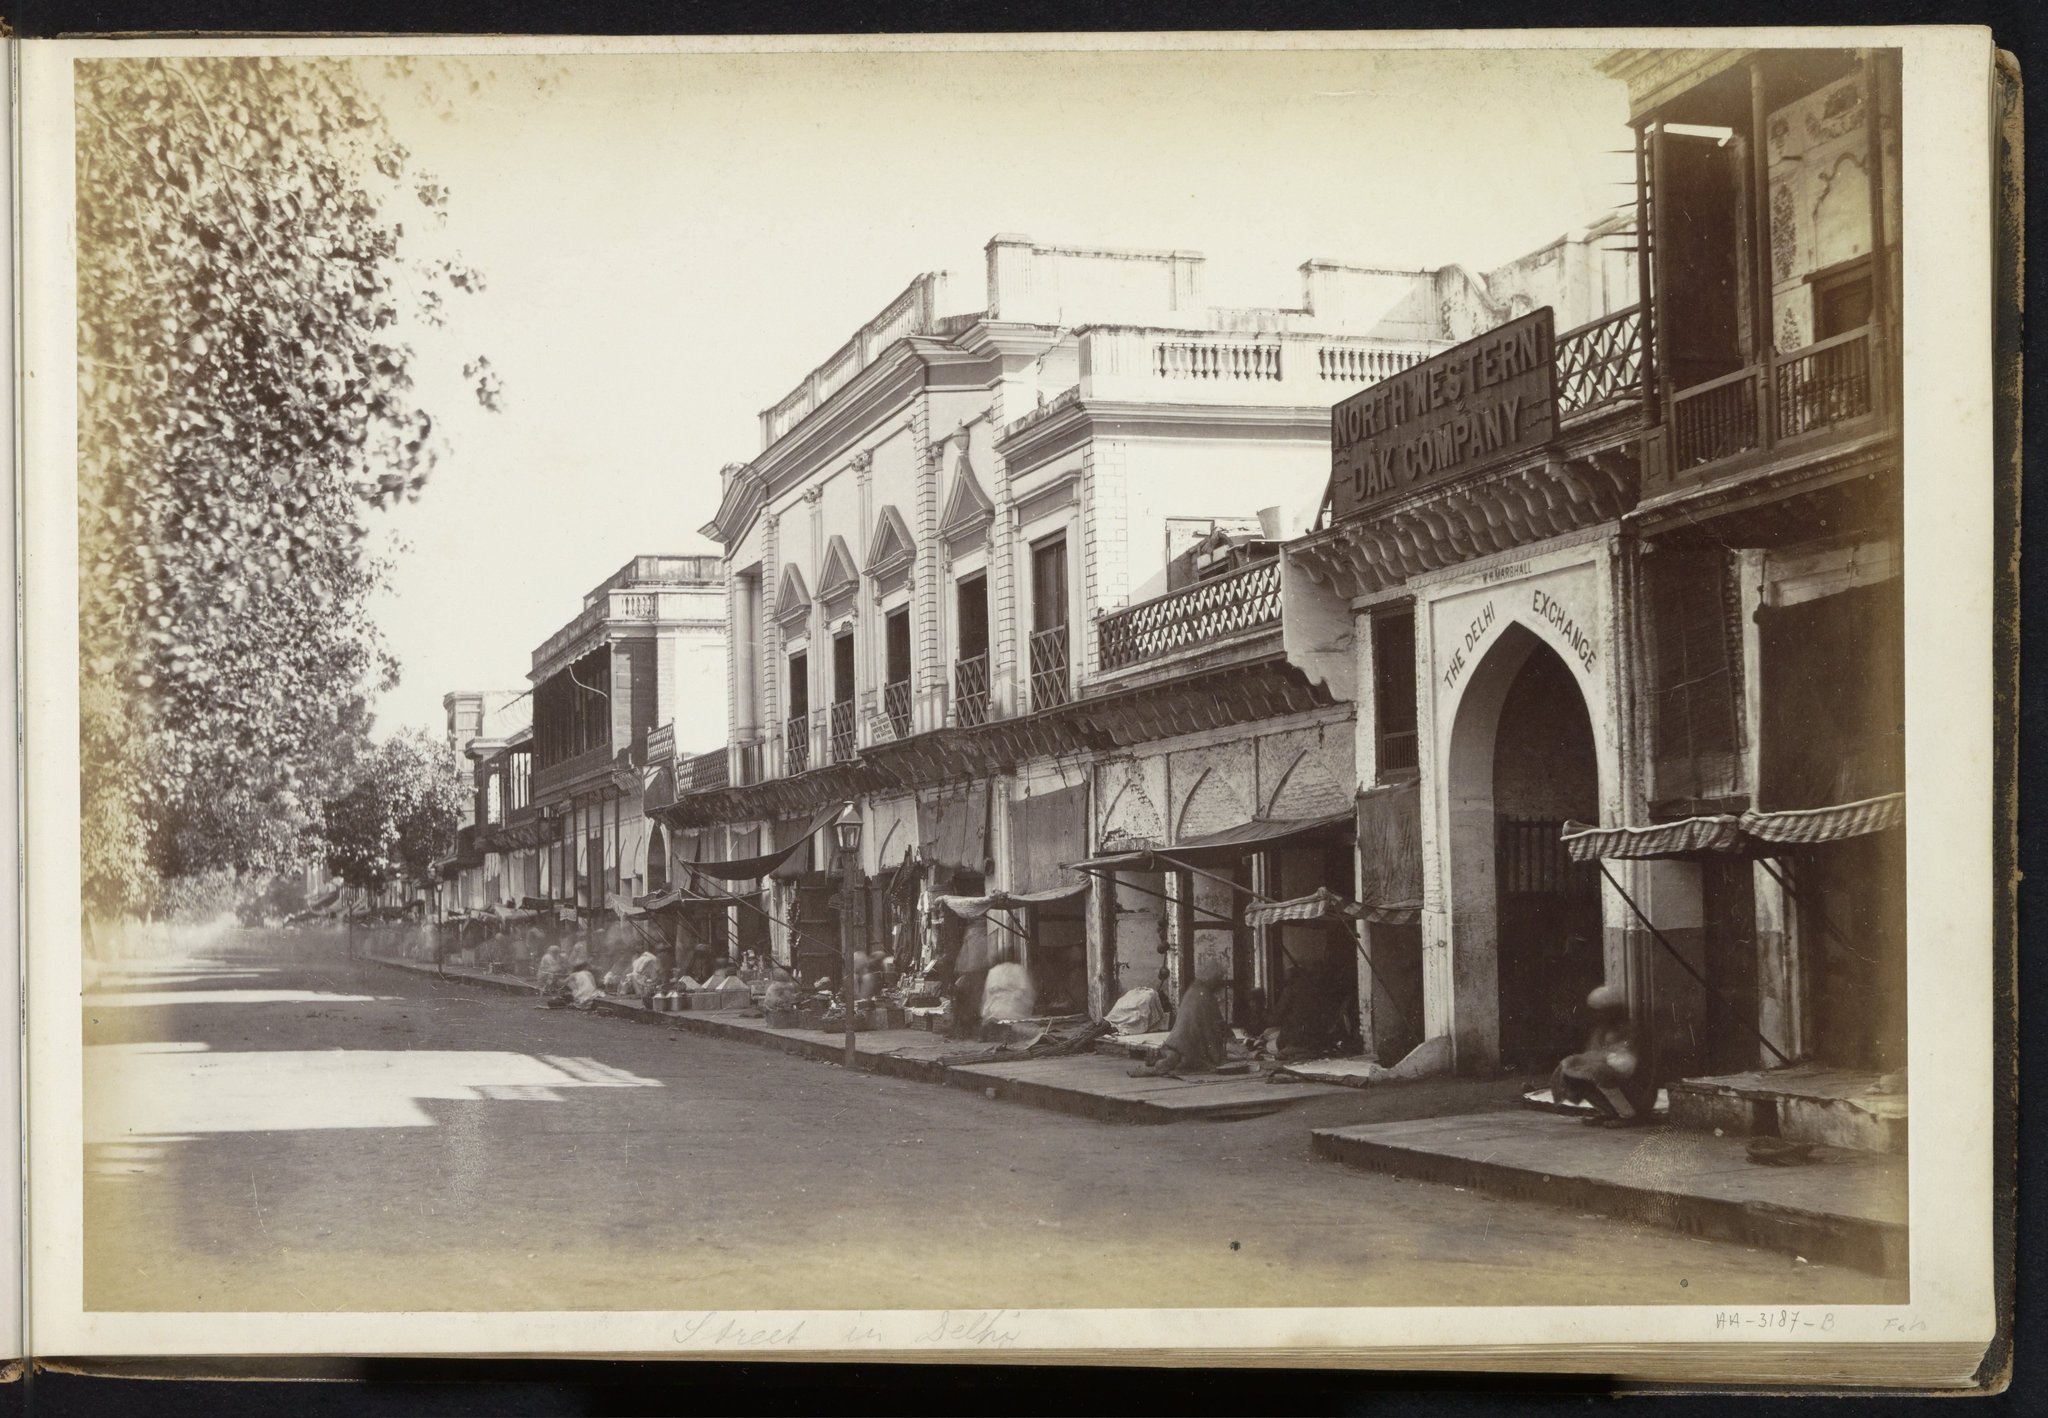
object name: photograph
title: Street view with shops such as the North Western Dâk Company and the entrance of the Delhi Exchange, Delhi, India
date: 1862-1863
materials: photographic support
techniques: albumen print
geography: delhi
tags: shop, store, travelling; tourism, workshop, street (+ city(-scape) with figures, staffage)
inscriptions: title: ‘Street in Delhi’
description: Onderdeel van Reisalbum met opnames van bezienswaardigheden in India, Duitsland, Zwitserland en Frankrijk.